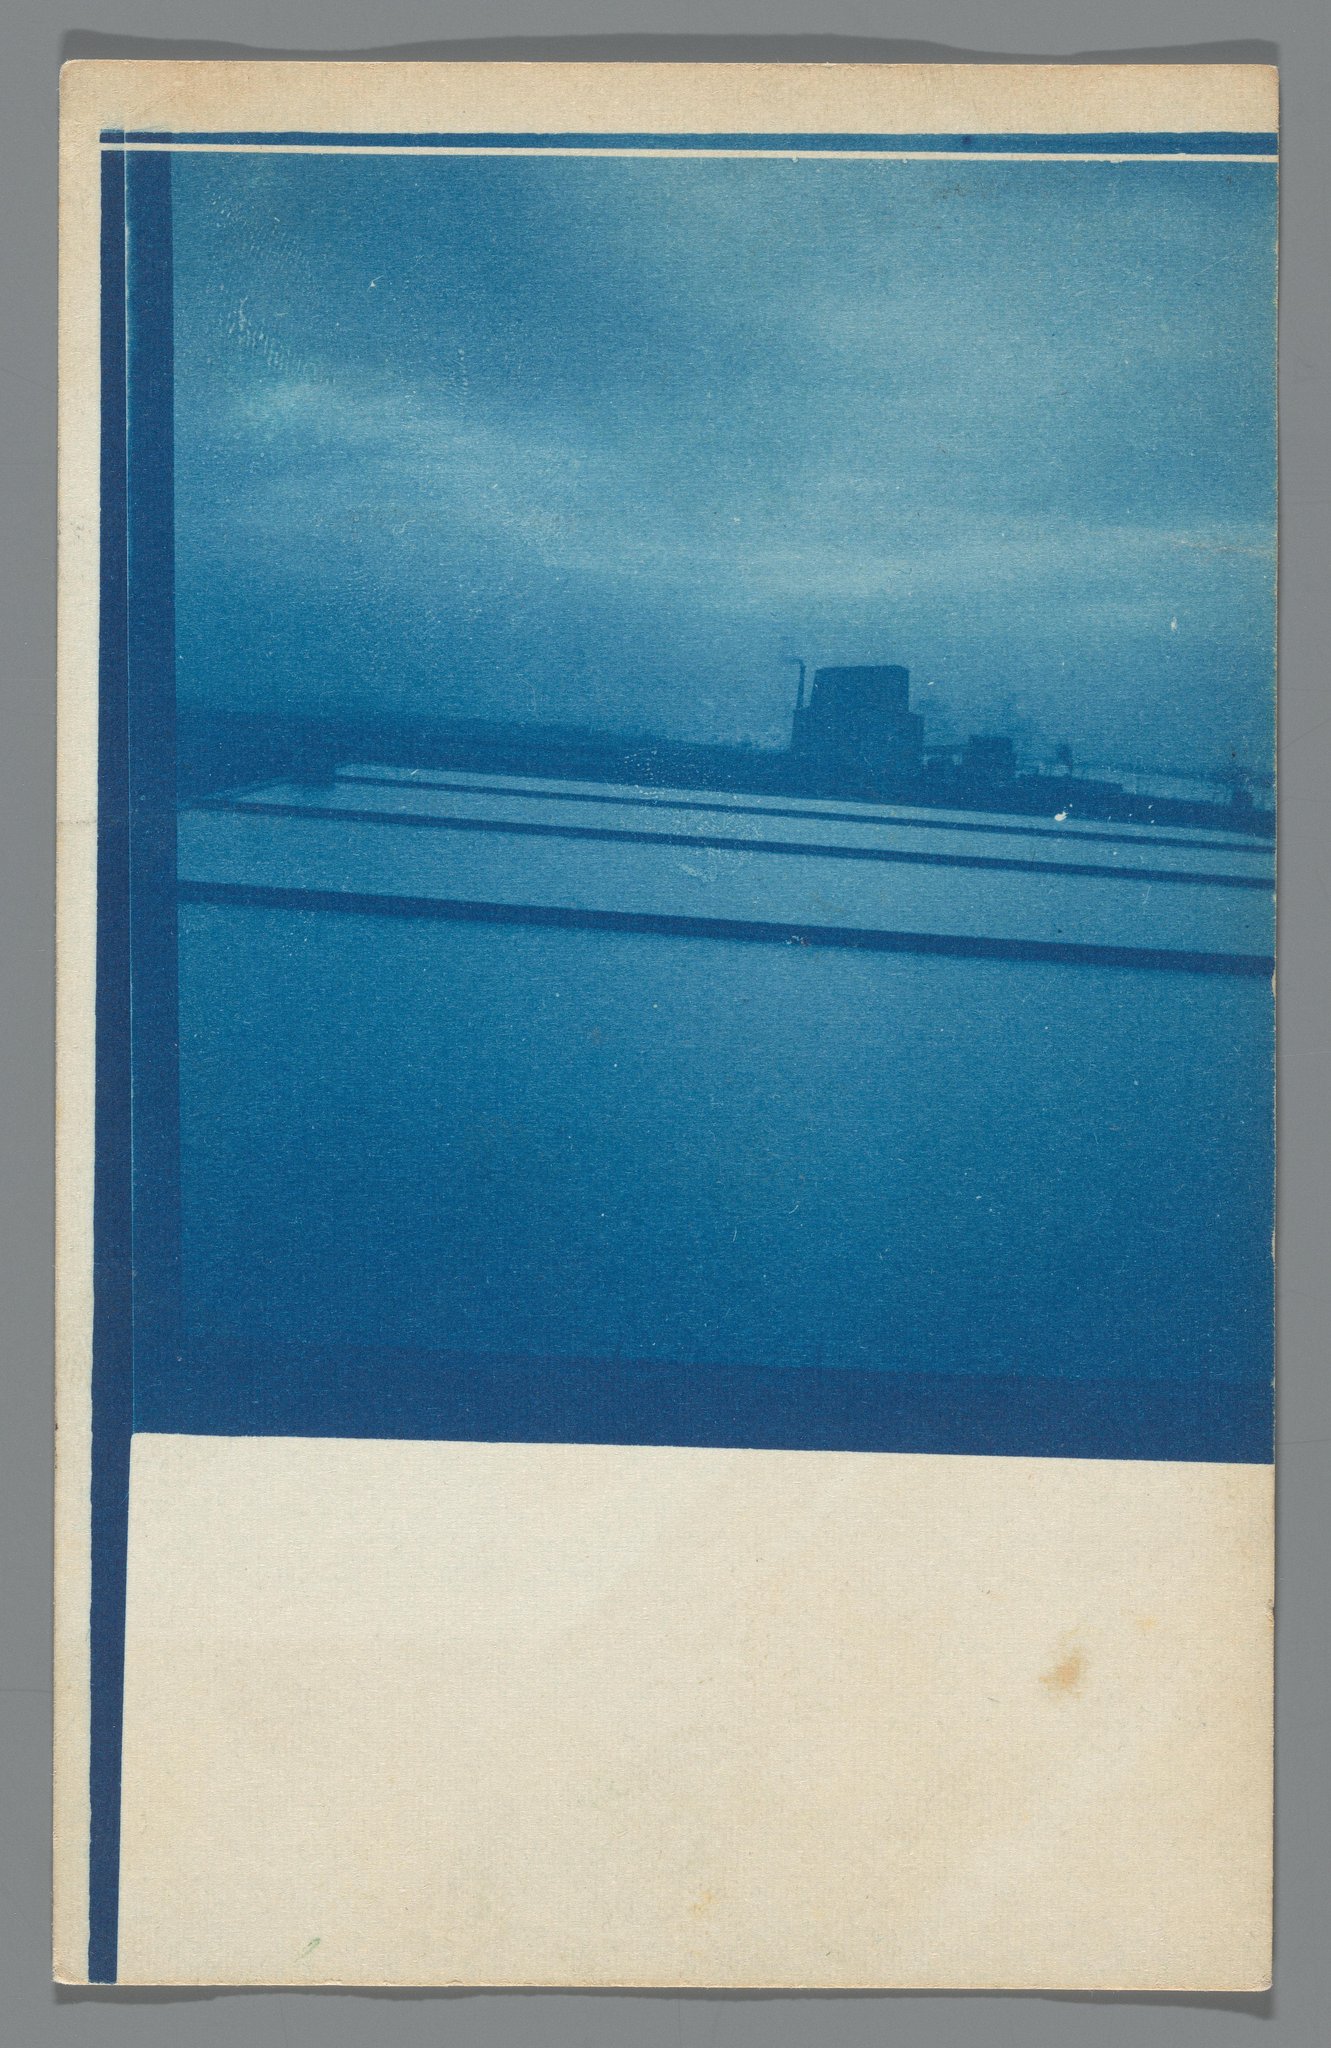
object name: ansichtkaart, prentbriefkaart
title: Gezicht op Saint Louis, Missouri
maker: Anonymous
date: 1909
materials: photographic support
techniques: cyanotype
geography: united states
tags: saint louis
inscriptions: : ‘1909’, inscription: ‘Am well and happy / but no work yet. / I took this as I was / going into St Louis, / and the day was very / dark, it is a fine / country aout here / but everything is high. / […]’